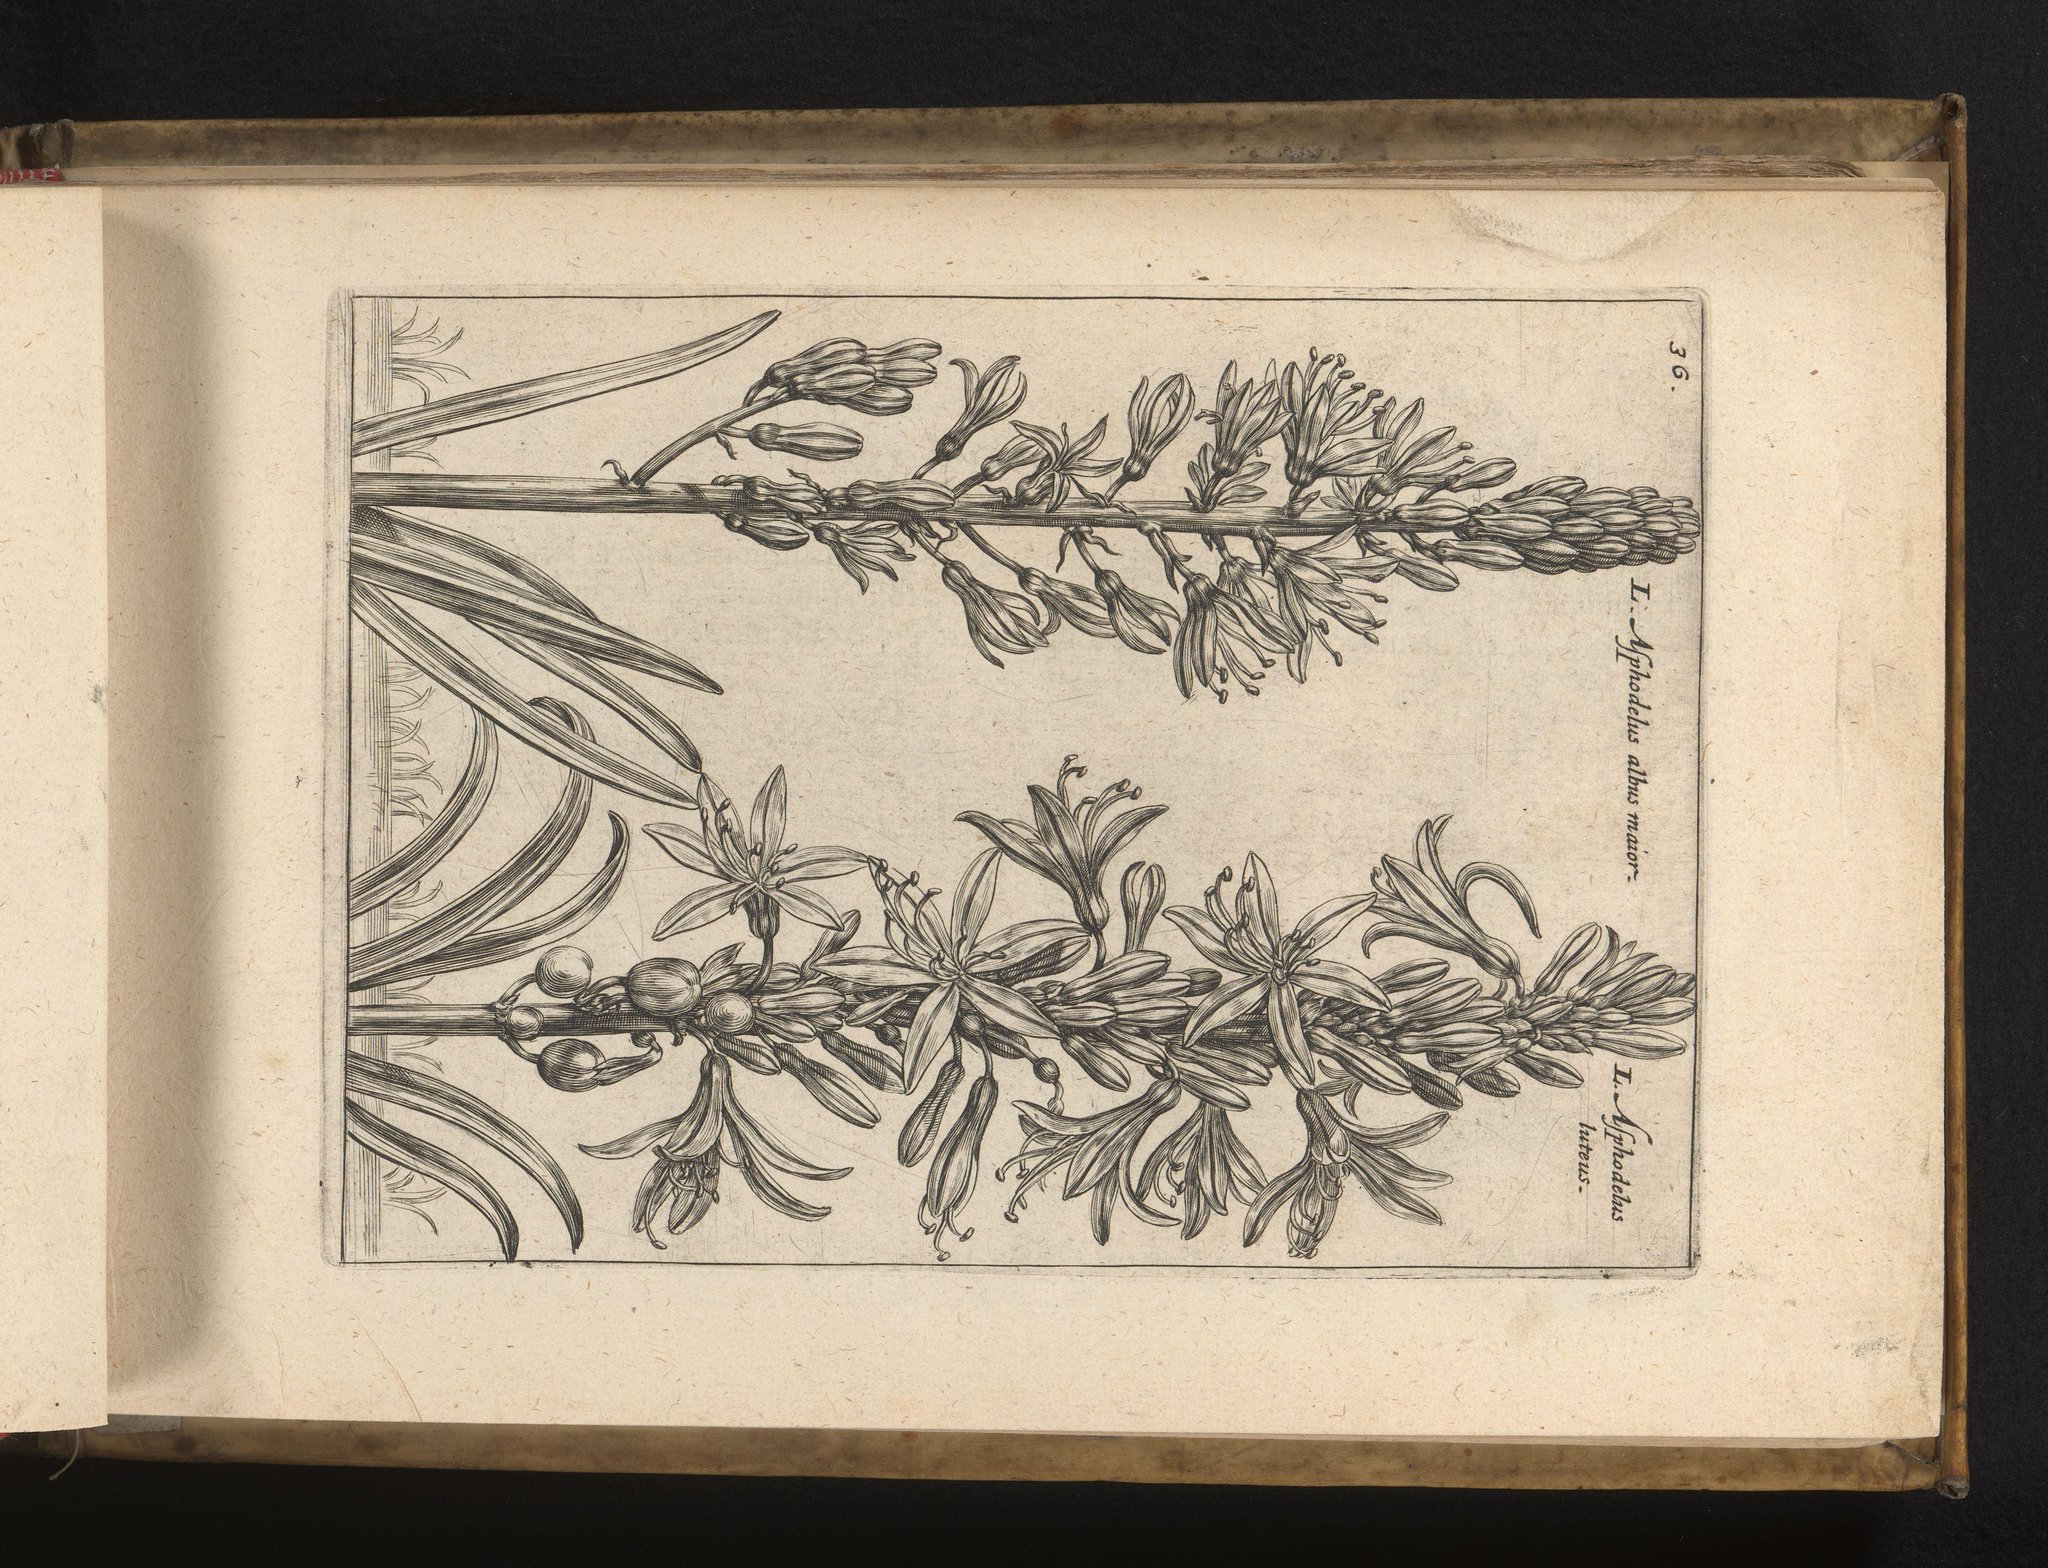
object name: book illustration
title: Bloemtuin van de lente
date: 1617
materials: paper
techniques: engraving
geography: arnhem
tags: flowers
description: Prent uit: Passe, Crispijn van de (II). Hortus floridus in quo rariorum & minus vulgarium florum icones ad vivam veramque formam. Arnhem: Johannes Janssonius, 1617.